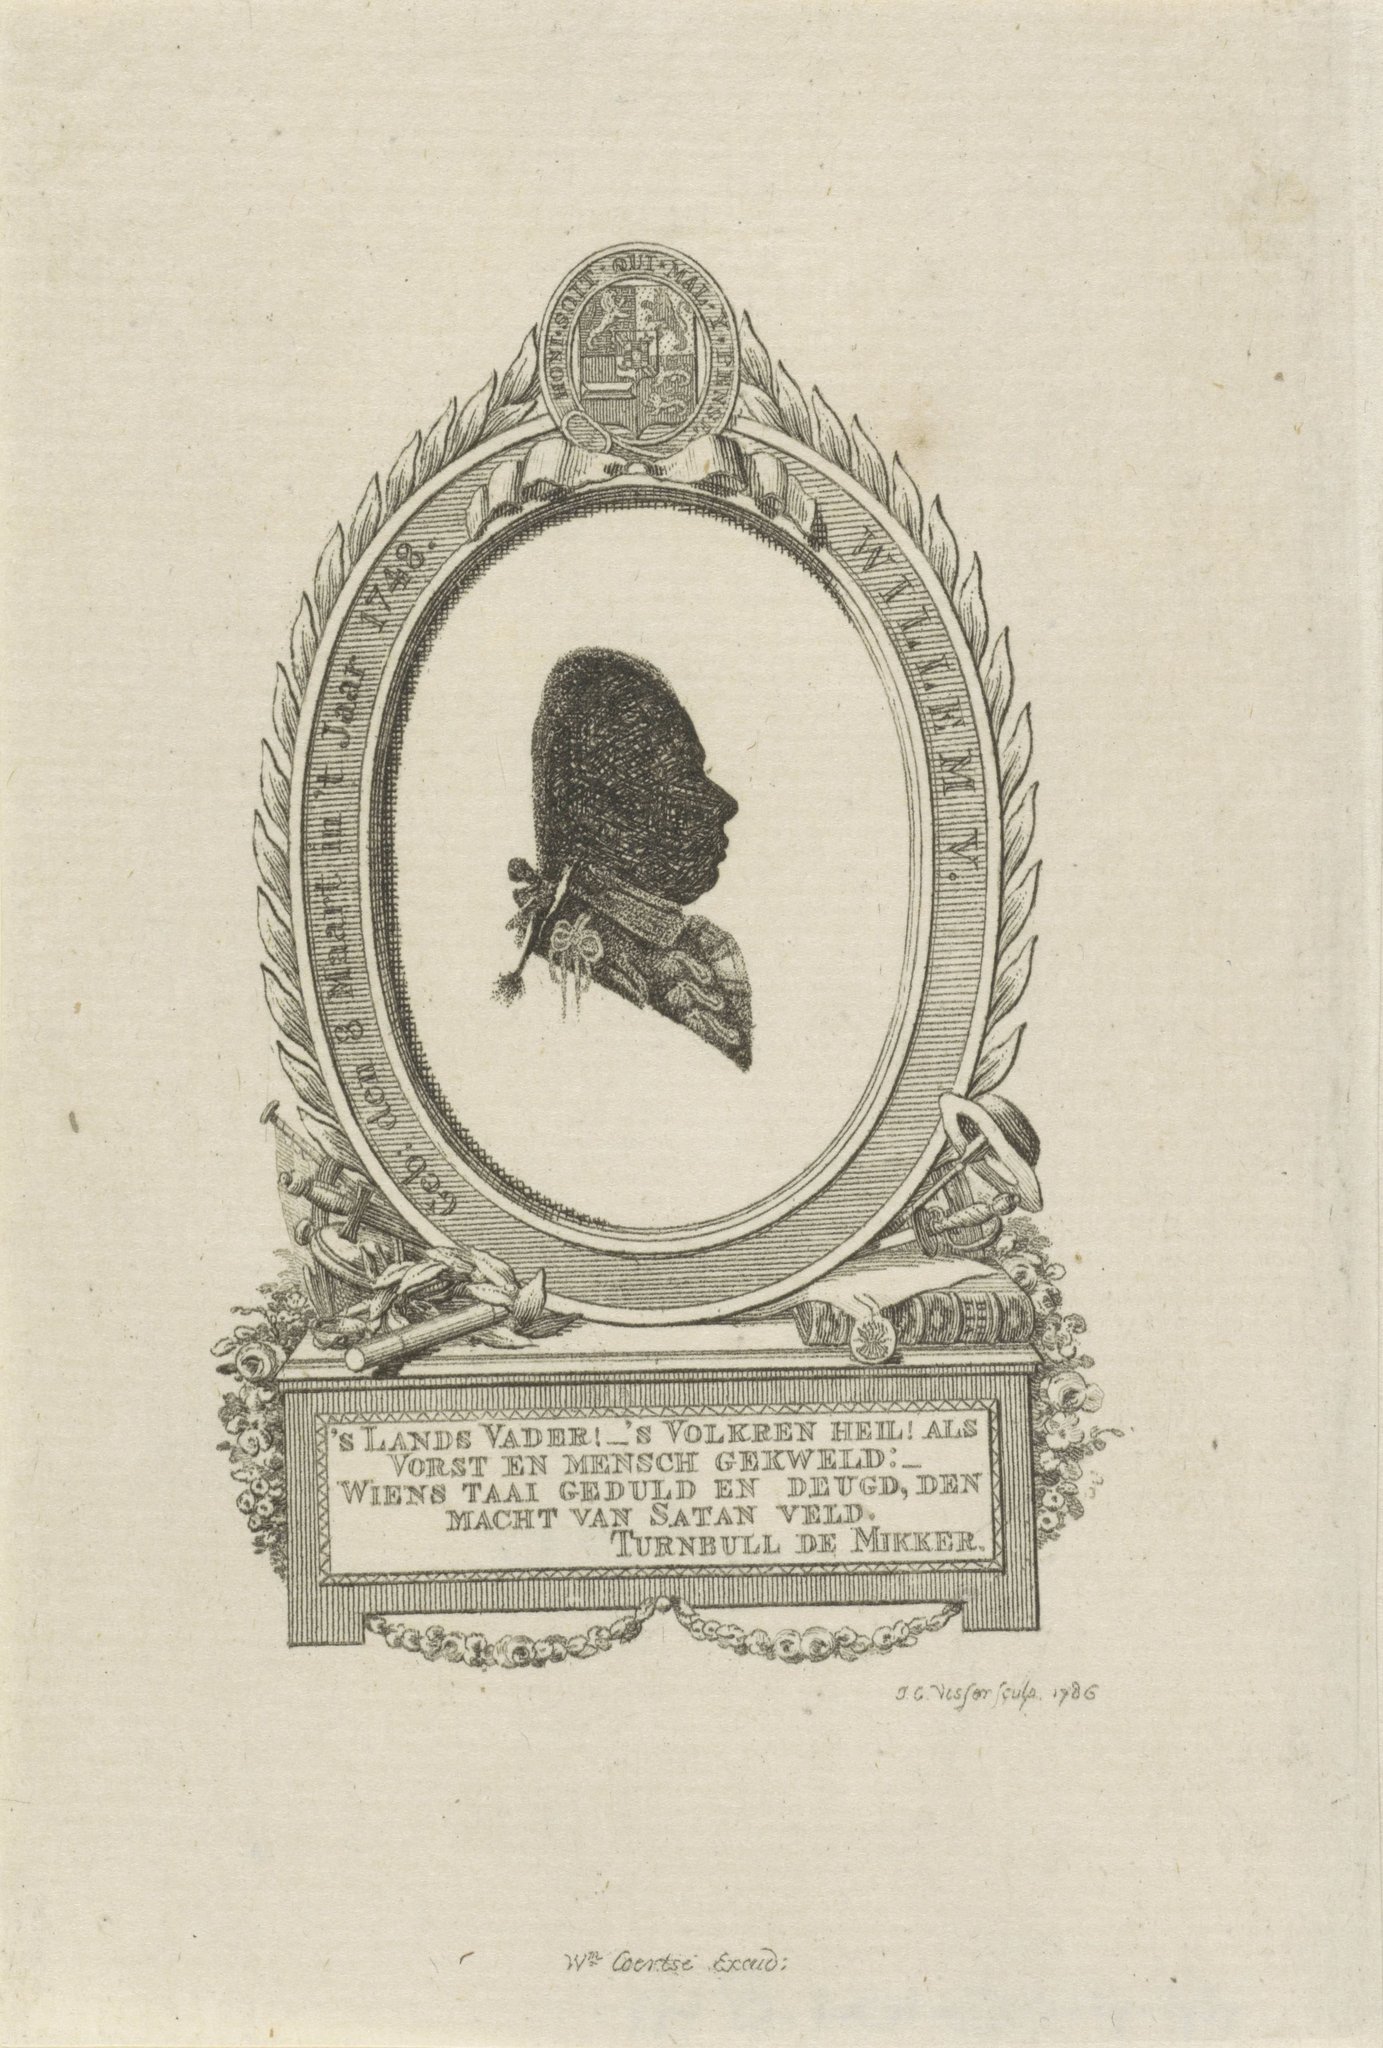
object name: print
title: Silhouetportret van Willem V, prins van Oranje-Nassau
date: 1786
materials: paper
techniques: engraving, etching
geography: amsterdam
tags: the hague, william v (prince of orange), knighthood order (garter) - insignia of a knighthood order, e.g.: badge, chain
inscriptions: date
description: Silhouetportret van Willem V in een ovaal met randschrift. Rondom ligt een aantal allegorische objecten. Midden boven zijn wapen, gedecoreerd met de Kousenband en het devies van de Orde van de Kousenband. Op een voetstuk vier regels Nederlandse tekst.